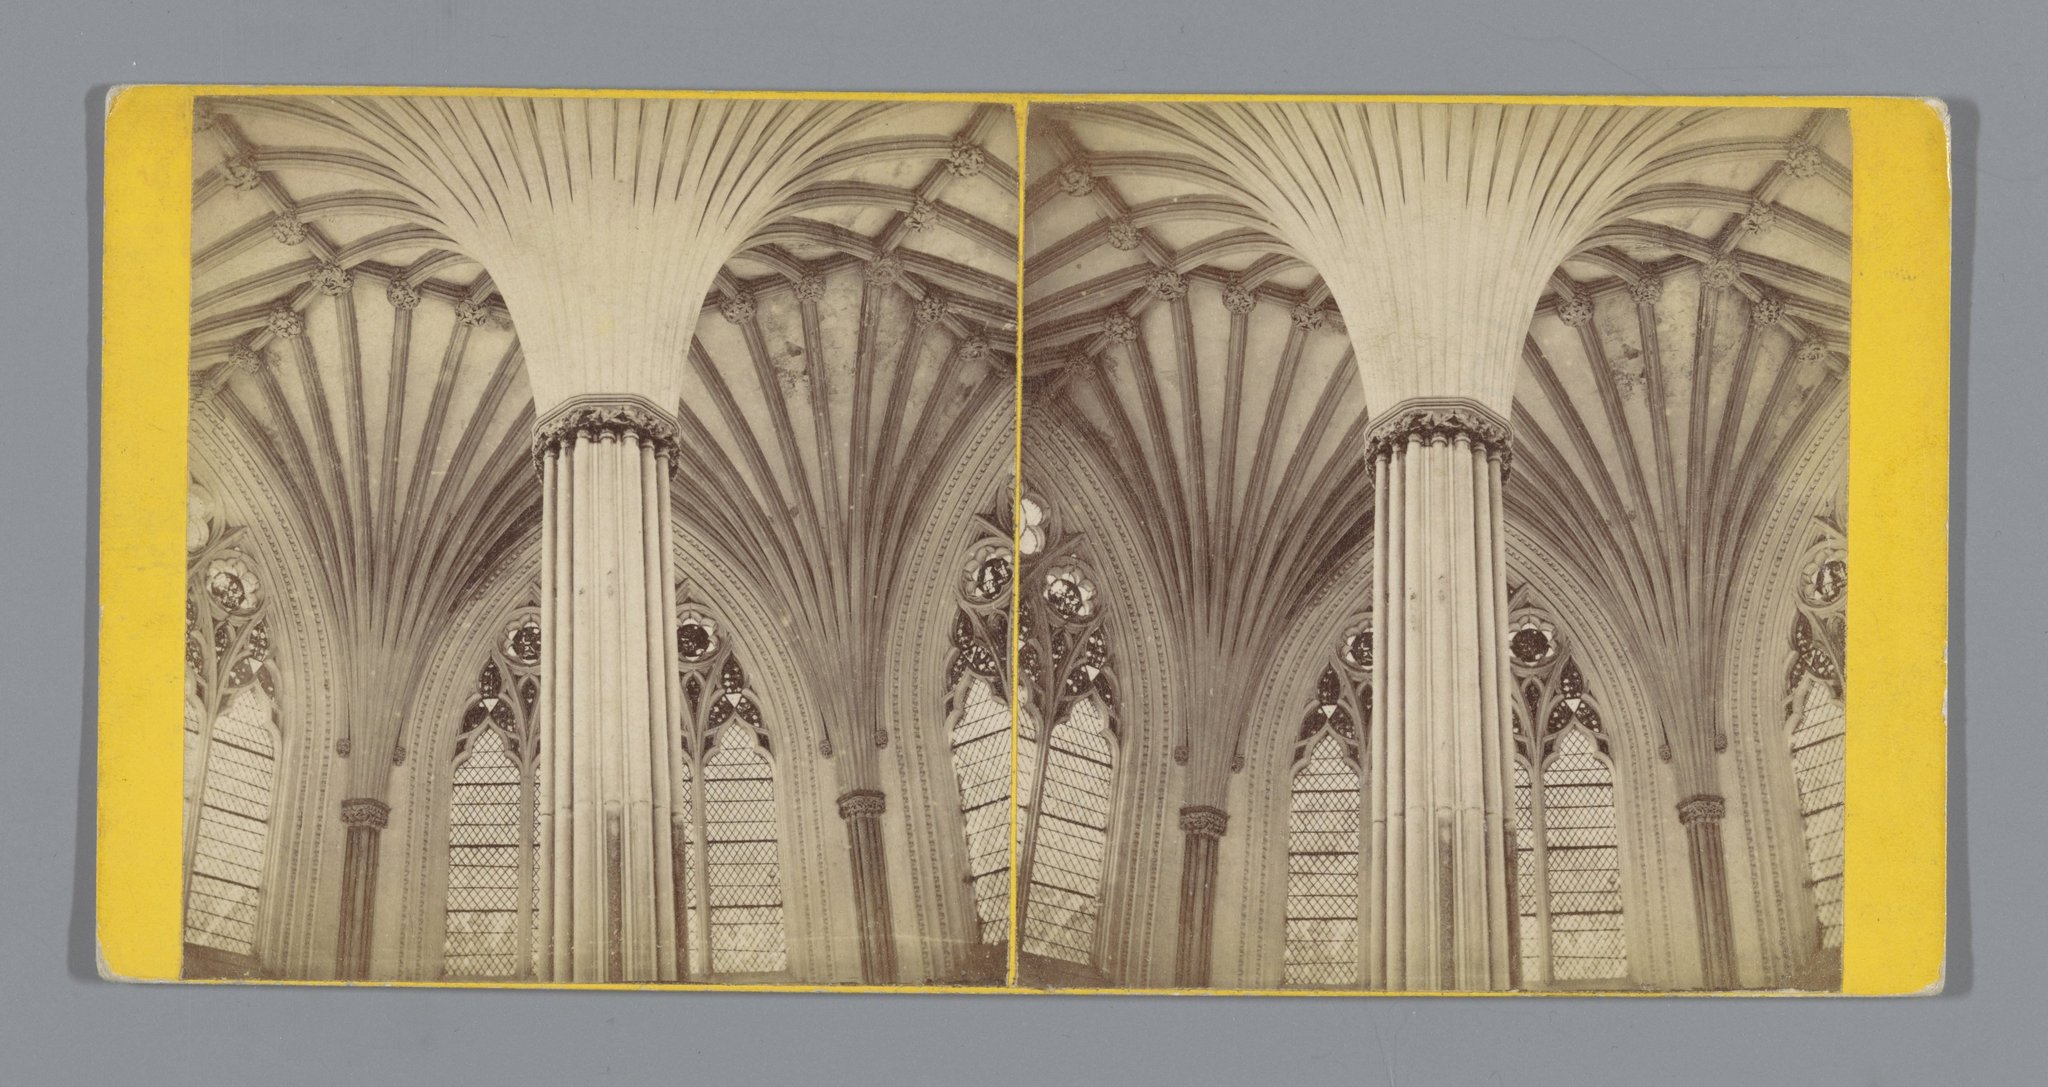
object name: stereograph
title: Wells Cathedral-Roof of the Chapter House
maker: george washington wilson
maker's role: publisher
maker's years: 1823-1893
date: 1858-1872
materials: cardboard, photographic support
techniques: albumen print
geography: wells cathedral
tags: parts of church interior: vault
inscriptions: number: ‘No. 650.’